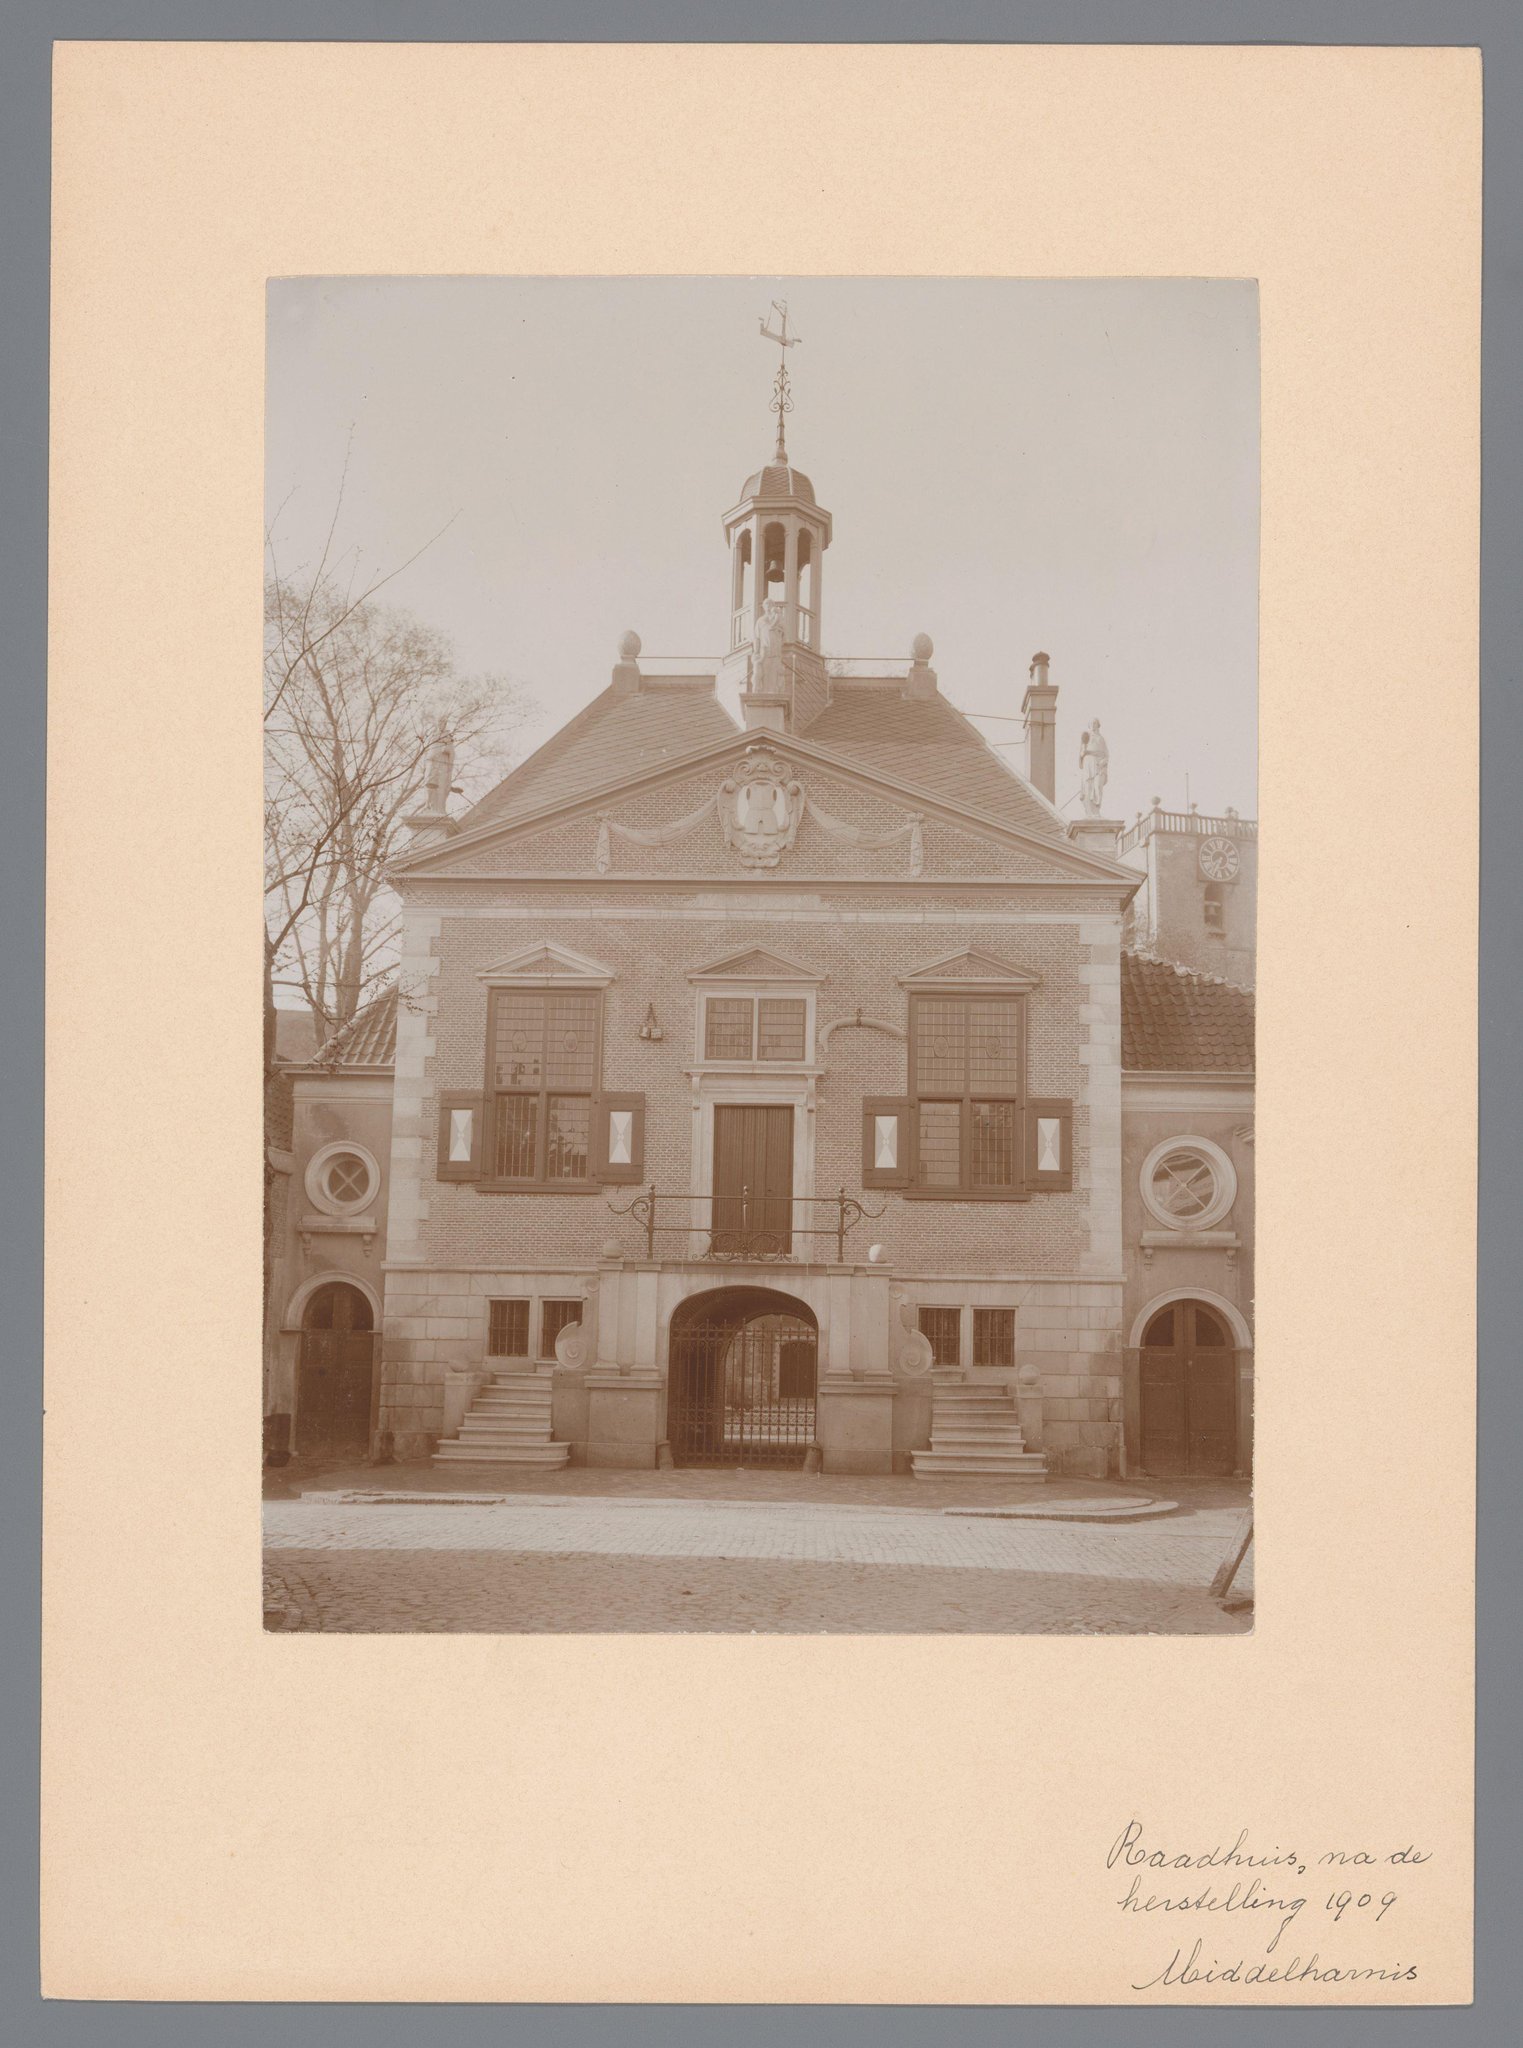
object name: photograph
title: Raadhuis van Middelharnis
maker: anoniem (monumentenzorg)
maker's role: fotograaf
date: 1909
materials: cardboard, photographic support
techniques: collodion silver print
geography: middelharnis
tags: townhall, façade (of house or building)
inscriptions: annotation: ‘Raadhuis, na de herstelling 1909/ Middelharnis’, annotation: ‘C. van Rhijn/ 1683-1745’